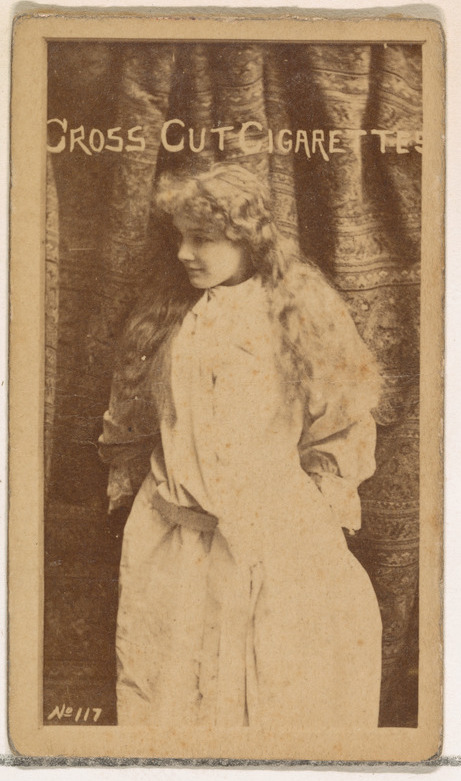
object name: print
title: Card Number 117, from the Actors and Actresses series (N145-1) issued by Duke Sons & Co. to promote Cross Cut Cigarettes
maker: w. duke, sons & co.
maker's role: publisher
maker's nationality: american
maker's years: 1870-1920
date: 1880-1889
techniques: albumen silver print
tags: portraits,women,actresses